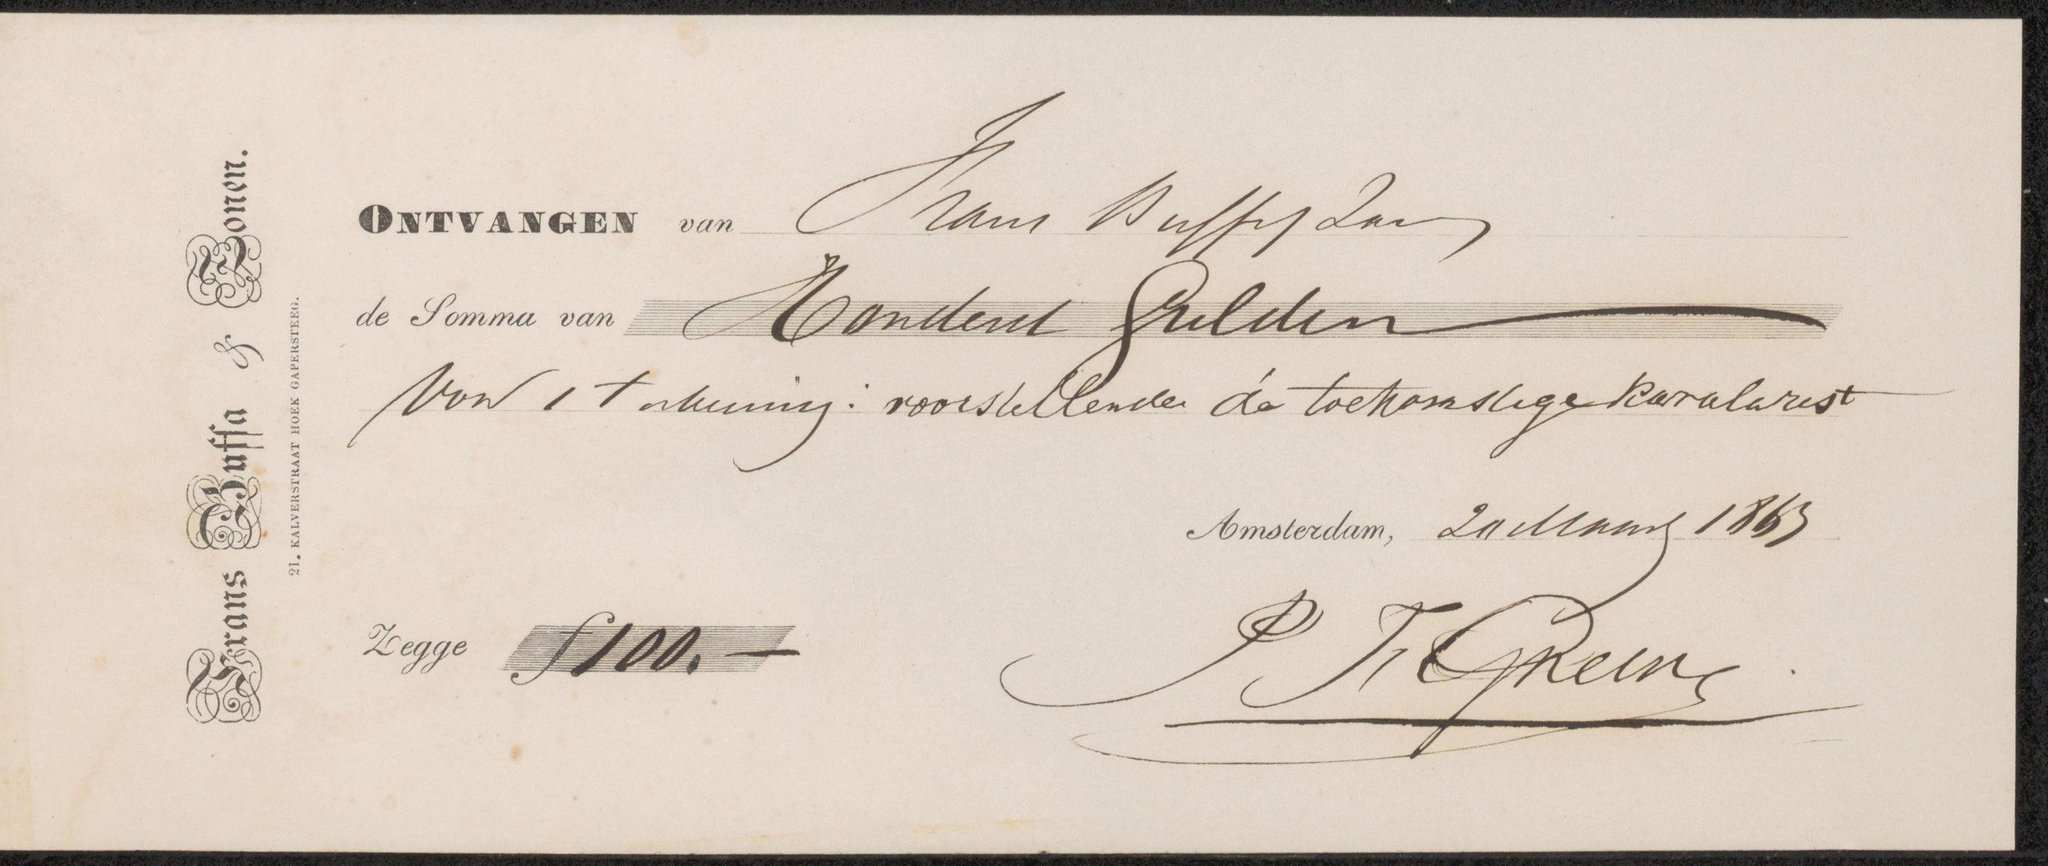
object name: ontvangstbewijs, kwitantie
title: Kwitantie voor Petrus Franciscus Greive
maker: petrus franciscus greive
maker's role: draughtsman, print maker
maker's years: 1811-1872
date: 1863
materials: ink, paper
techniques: pen, printing, writing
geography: amsterdam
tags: drawing, money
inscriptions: collector's mark: Lugt 2233